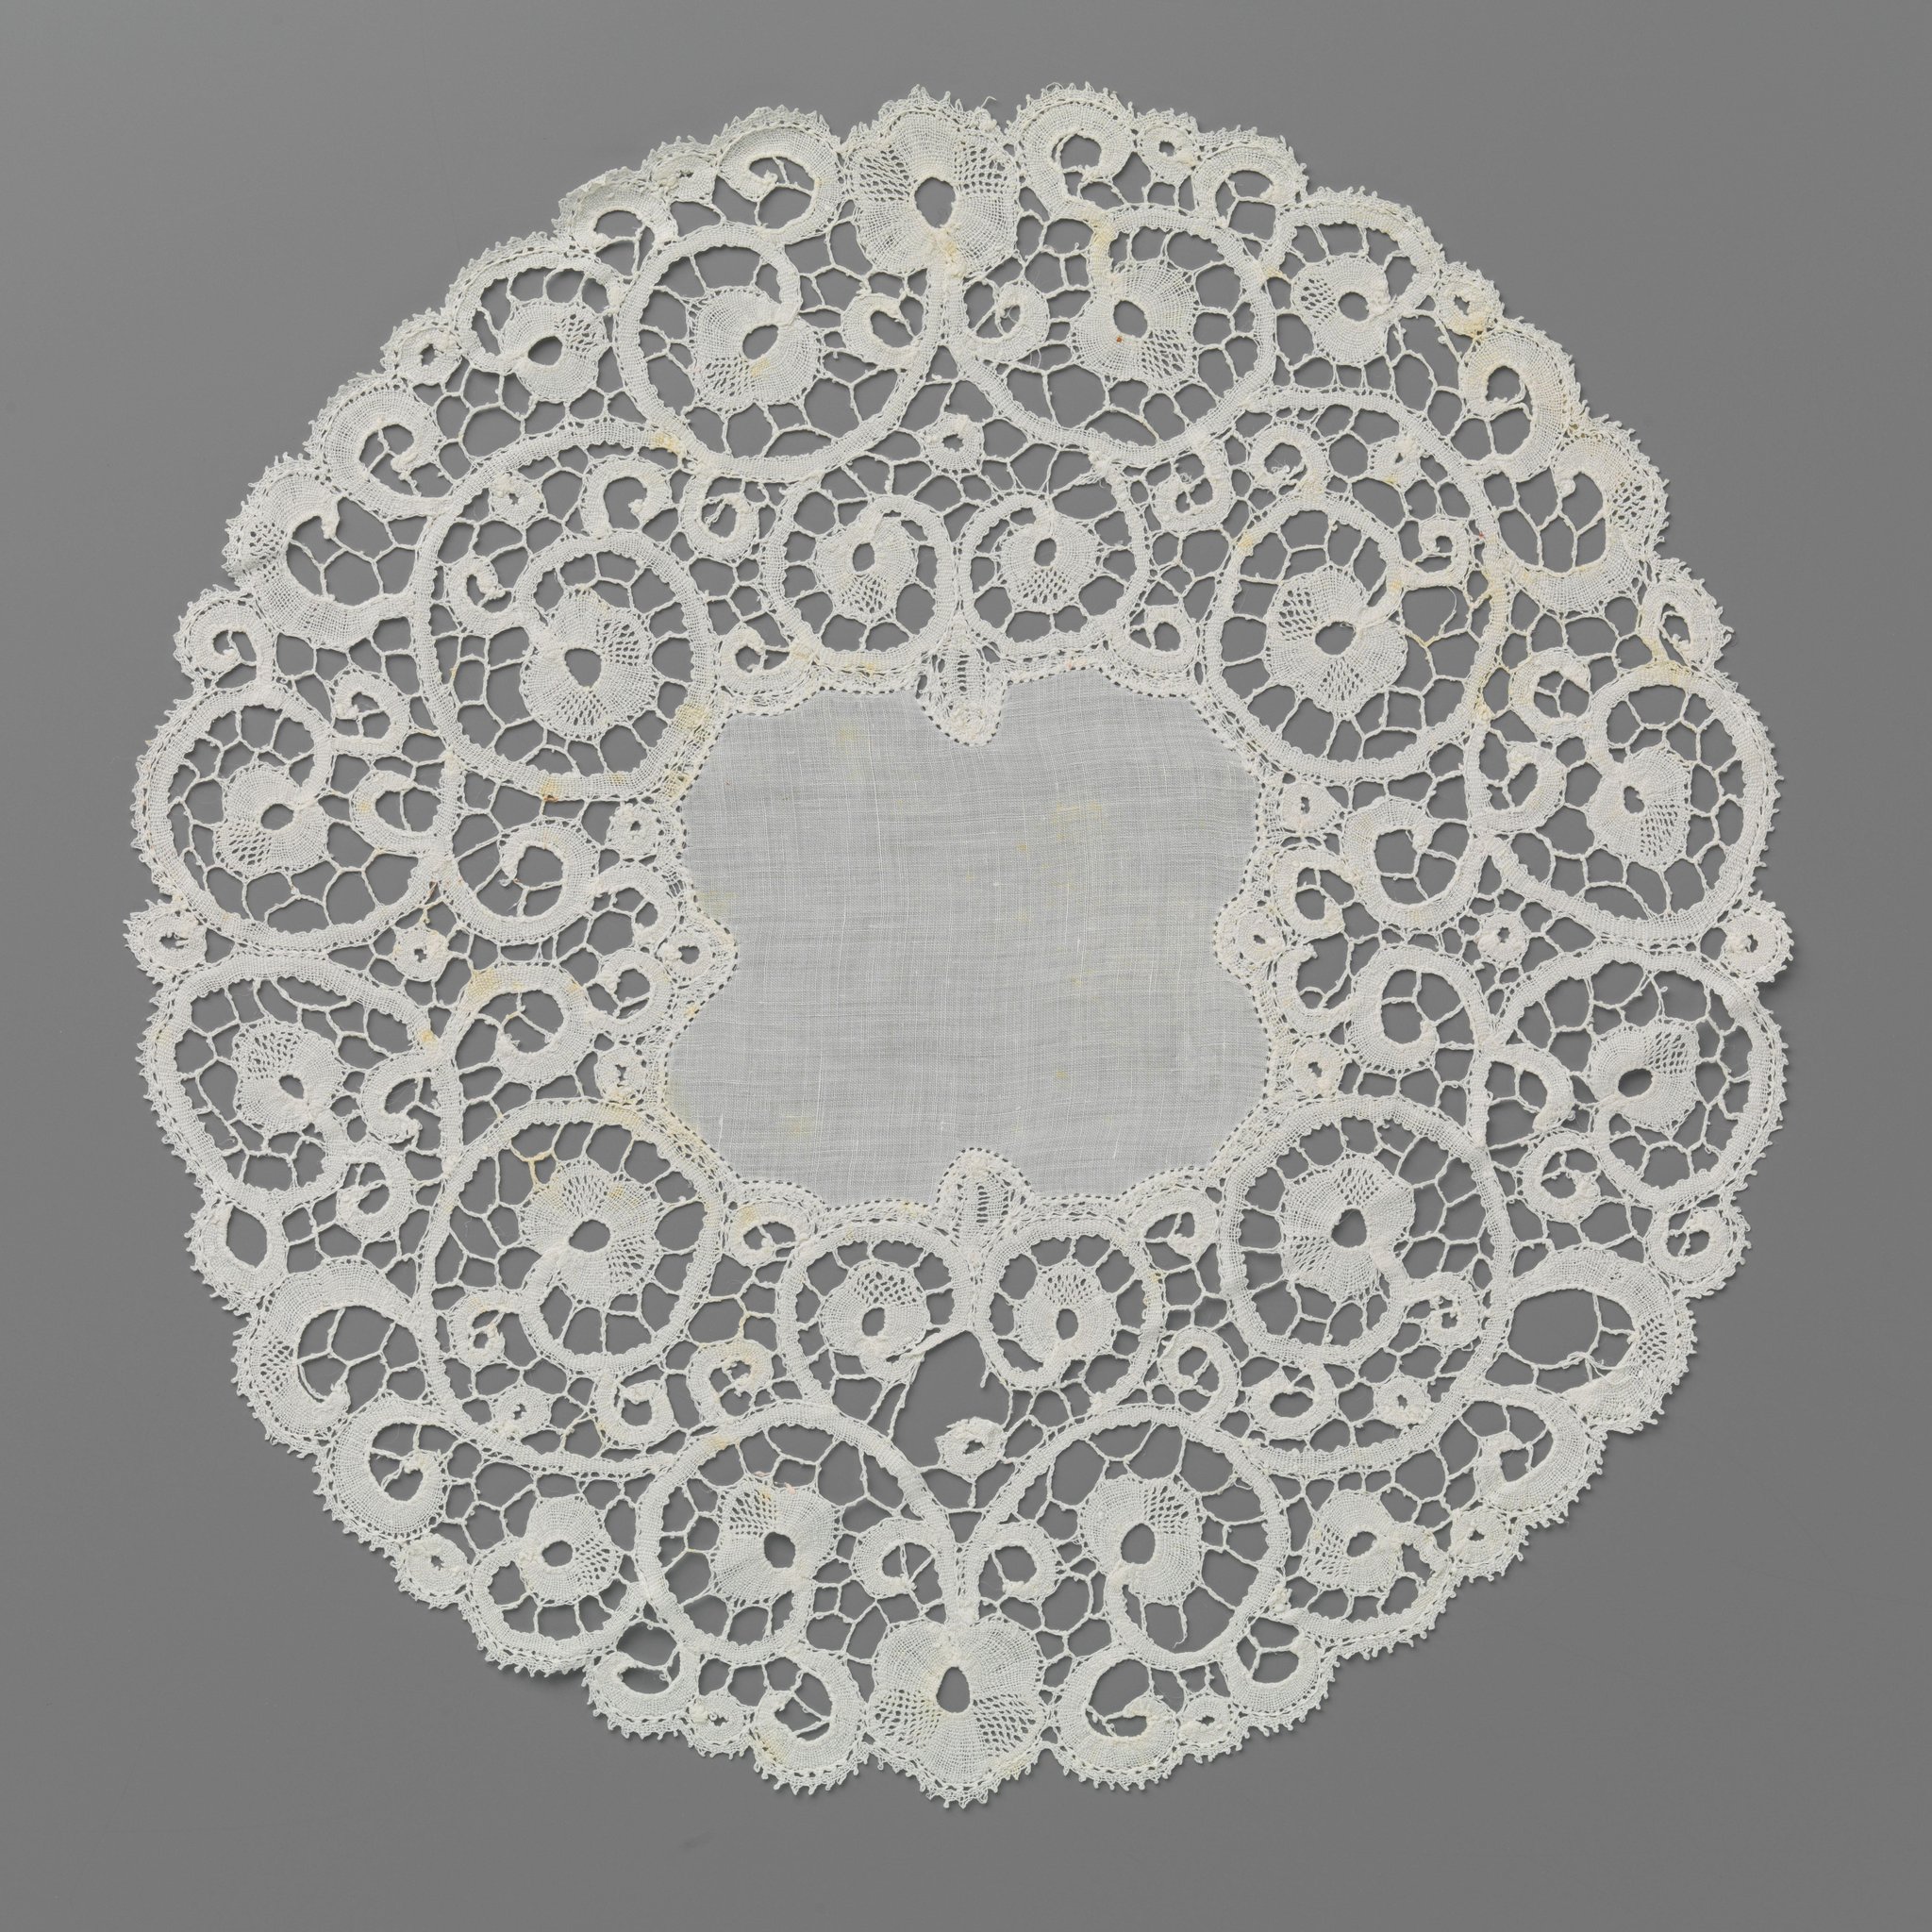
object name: kleed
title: Rond kleedje van achthoekig batist met rondom een brede rand kloskant met harten gevormd door omkrullende bloemranken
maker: Anonymous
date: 1900-1924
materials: cotton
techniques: lace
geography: italy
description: Kleedje van naturelkleurige batist met rondom een brede rand kloskant: lintkant. Rond model met een klein achthoekig geschulpt binnenstuk van batist. Het kantpatroon bestaat uit omkrullende bloemranken gevormd door smalle linten en is symmetrisch ten opzichte van één midden-as. De ranken vormen langs twee tegenoverliggende zijden van het batist een hart. De krullen eindigen afwisselend in een rozetbloem of een peervormige bloem, met een uitgespaard bloemhart. De motieven zijn gemaakt in linnenslag en zijn met elkaar verbonden door een vlechtengrond. Een deel van de bloemblaadjes is gemaakt in een tralieslag. De schulpenrand langs de buitenrand van het kleedje komt voort uit het patroon en is afgewerkt met een smal lintje met picots.